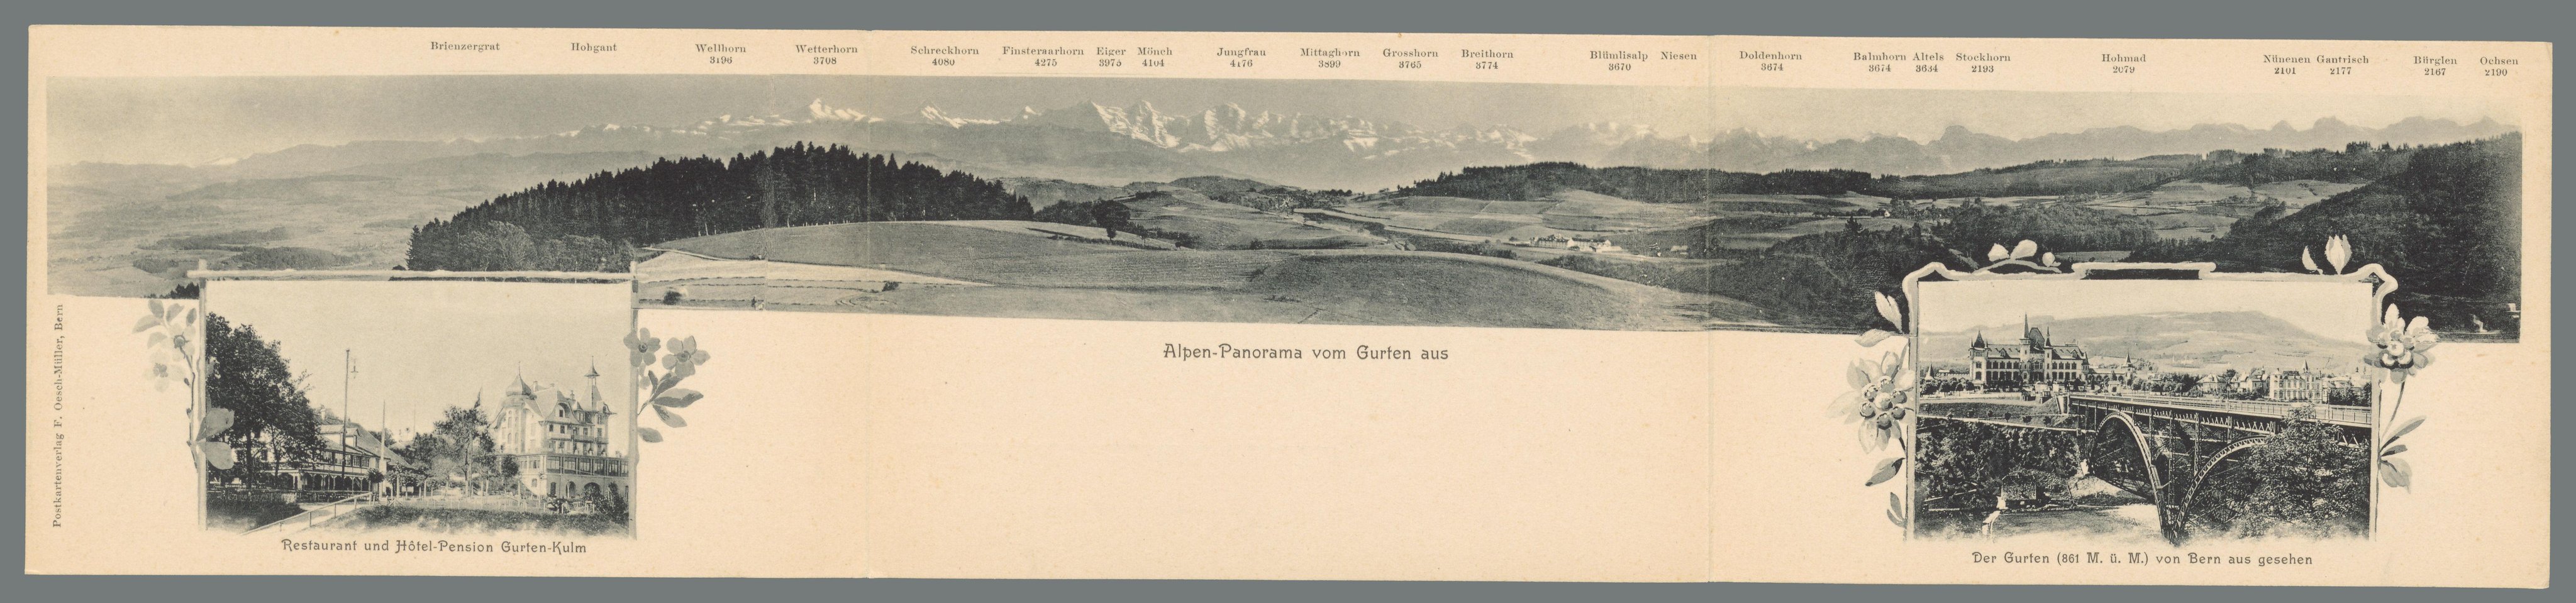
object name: ansichtkaart, prentbriefkaart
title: Alpen-Panorama vom Gurten aus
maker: Anonymous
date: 1890-1905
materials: cardboard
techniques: photograph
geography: bern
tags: mountain-range, snow peaks, hotel, hostelry, inn